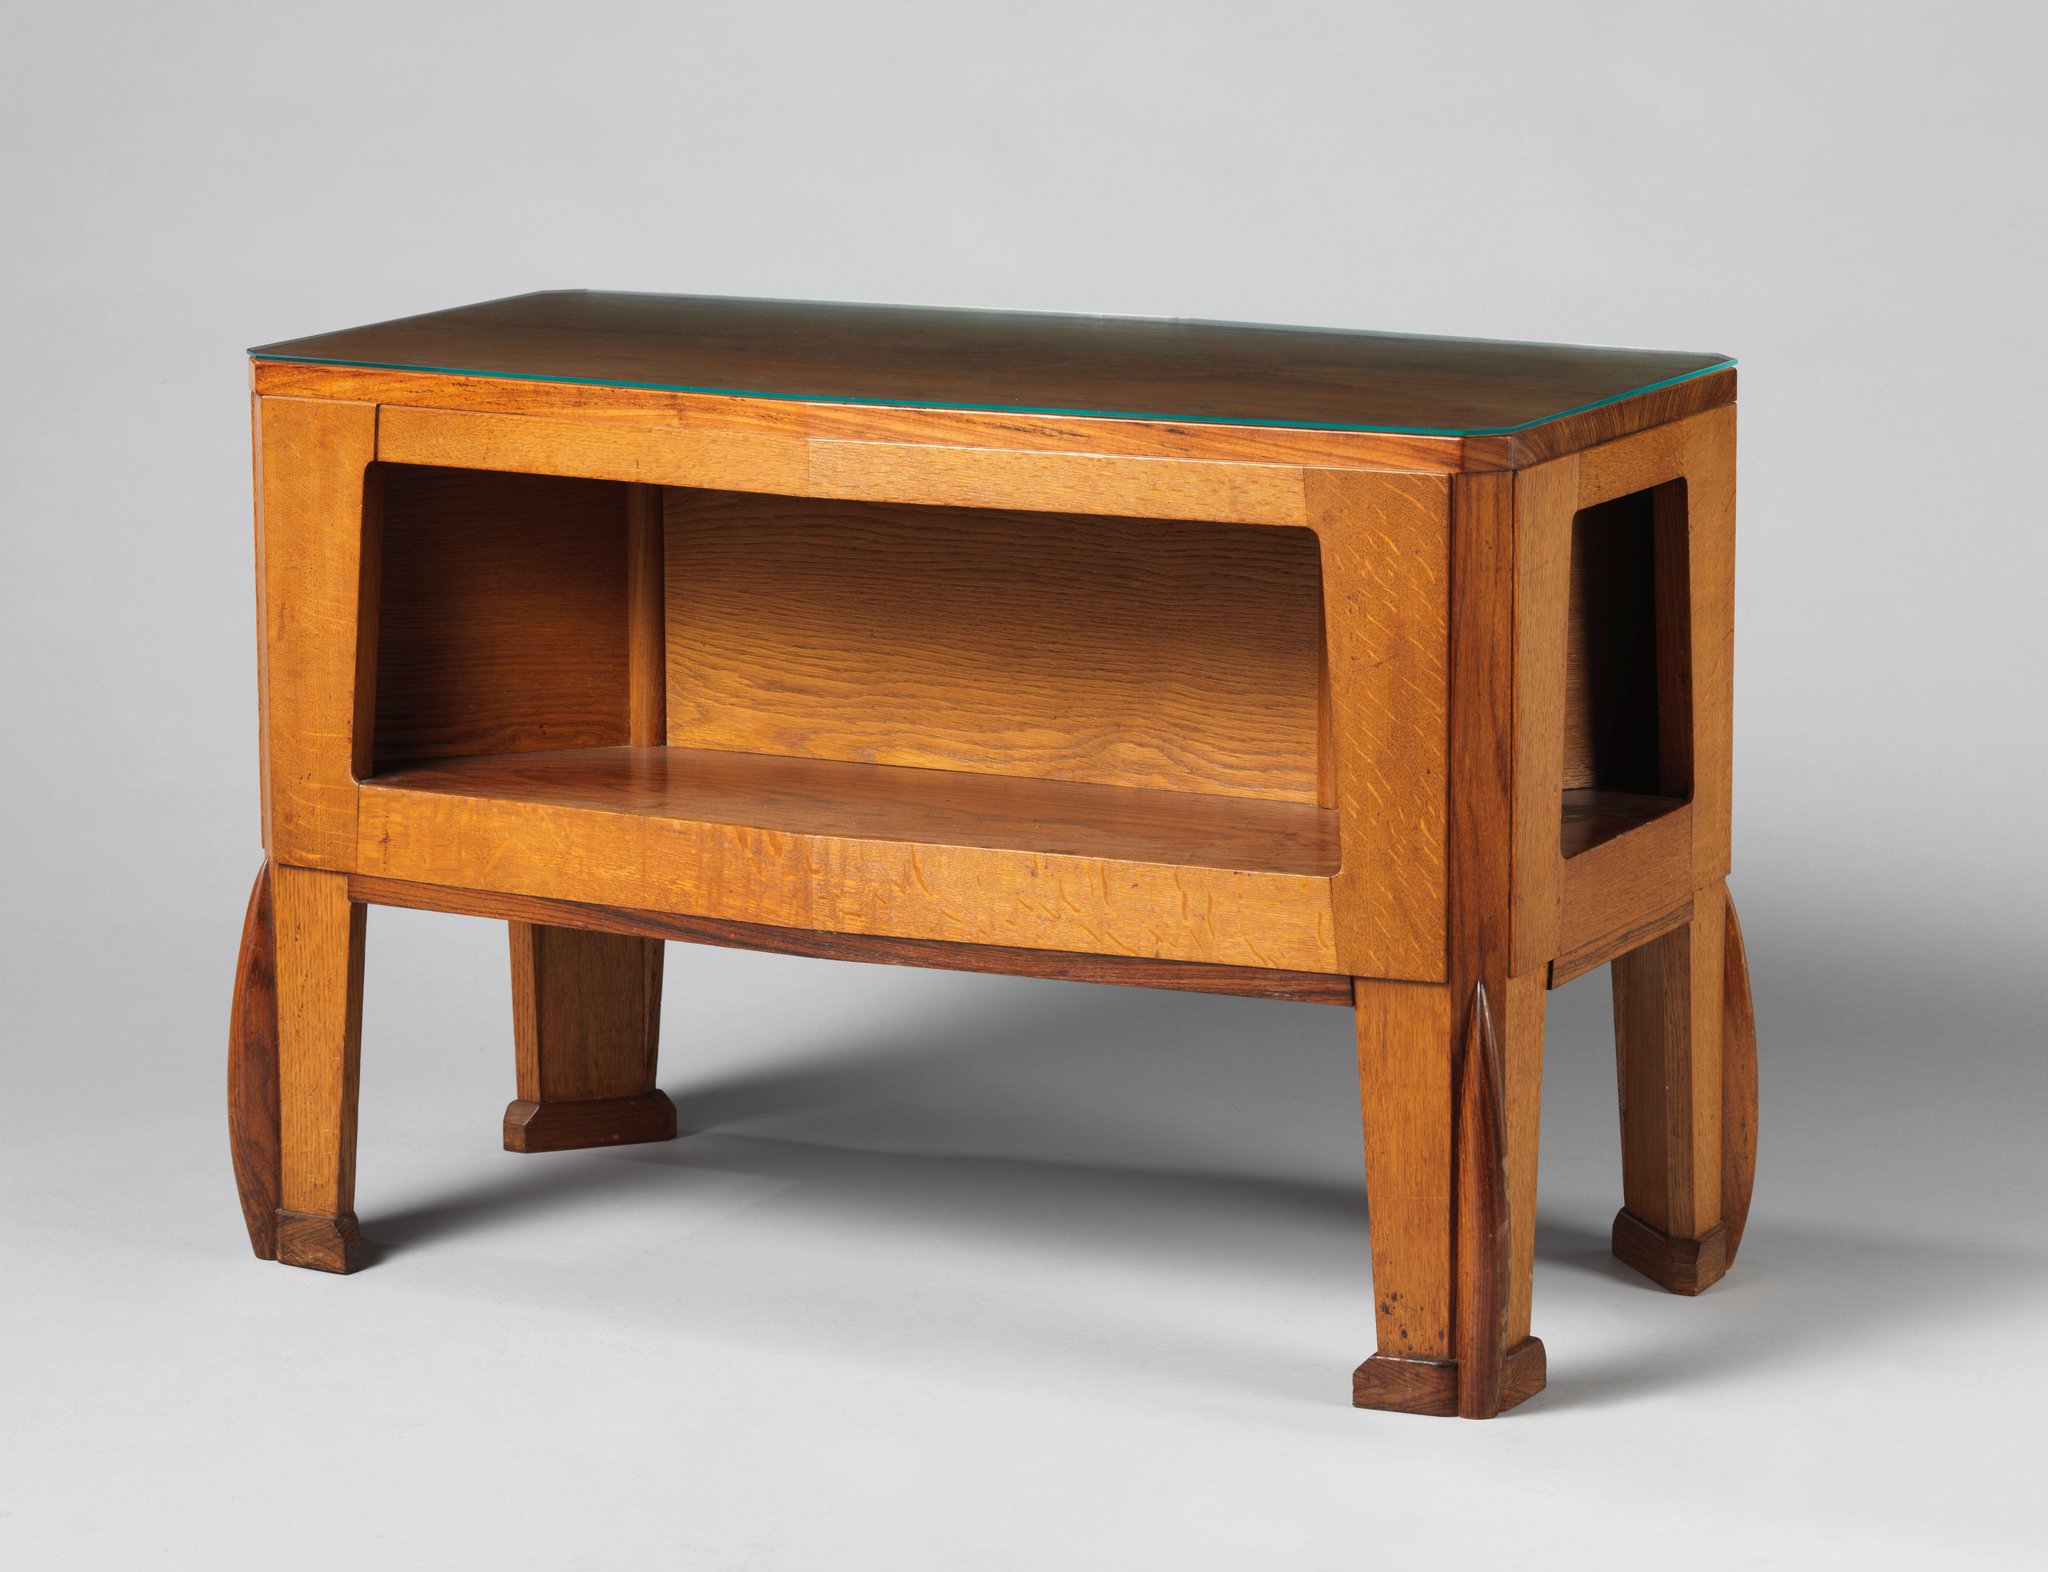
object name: furniture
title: Salontafel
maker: ernst schubad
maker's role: interieurontwerper, meubelontwerper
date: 1920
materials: glass, wood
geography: netherlands